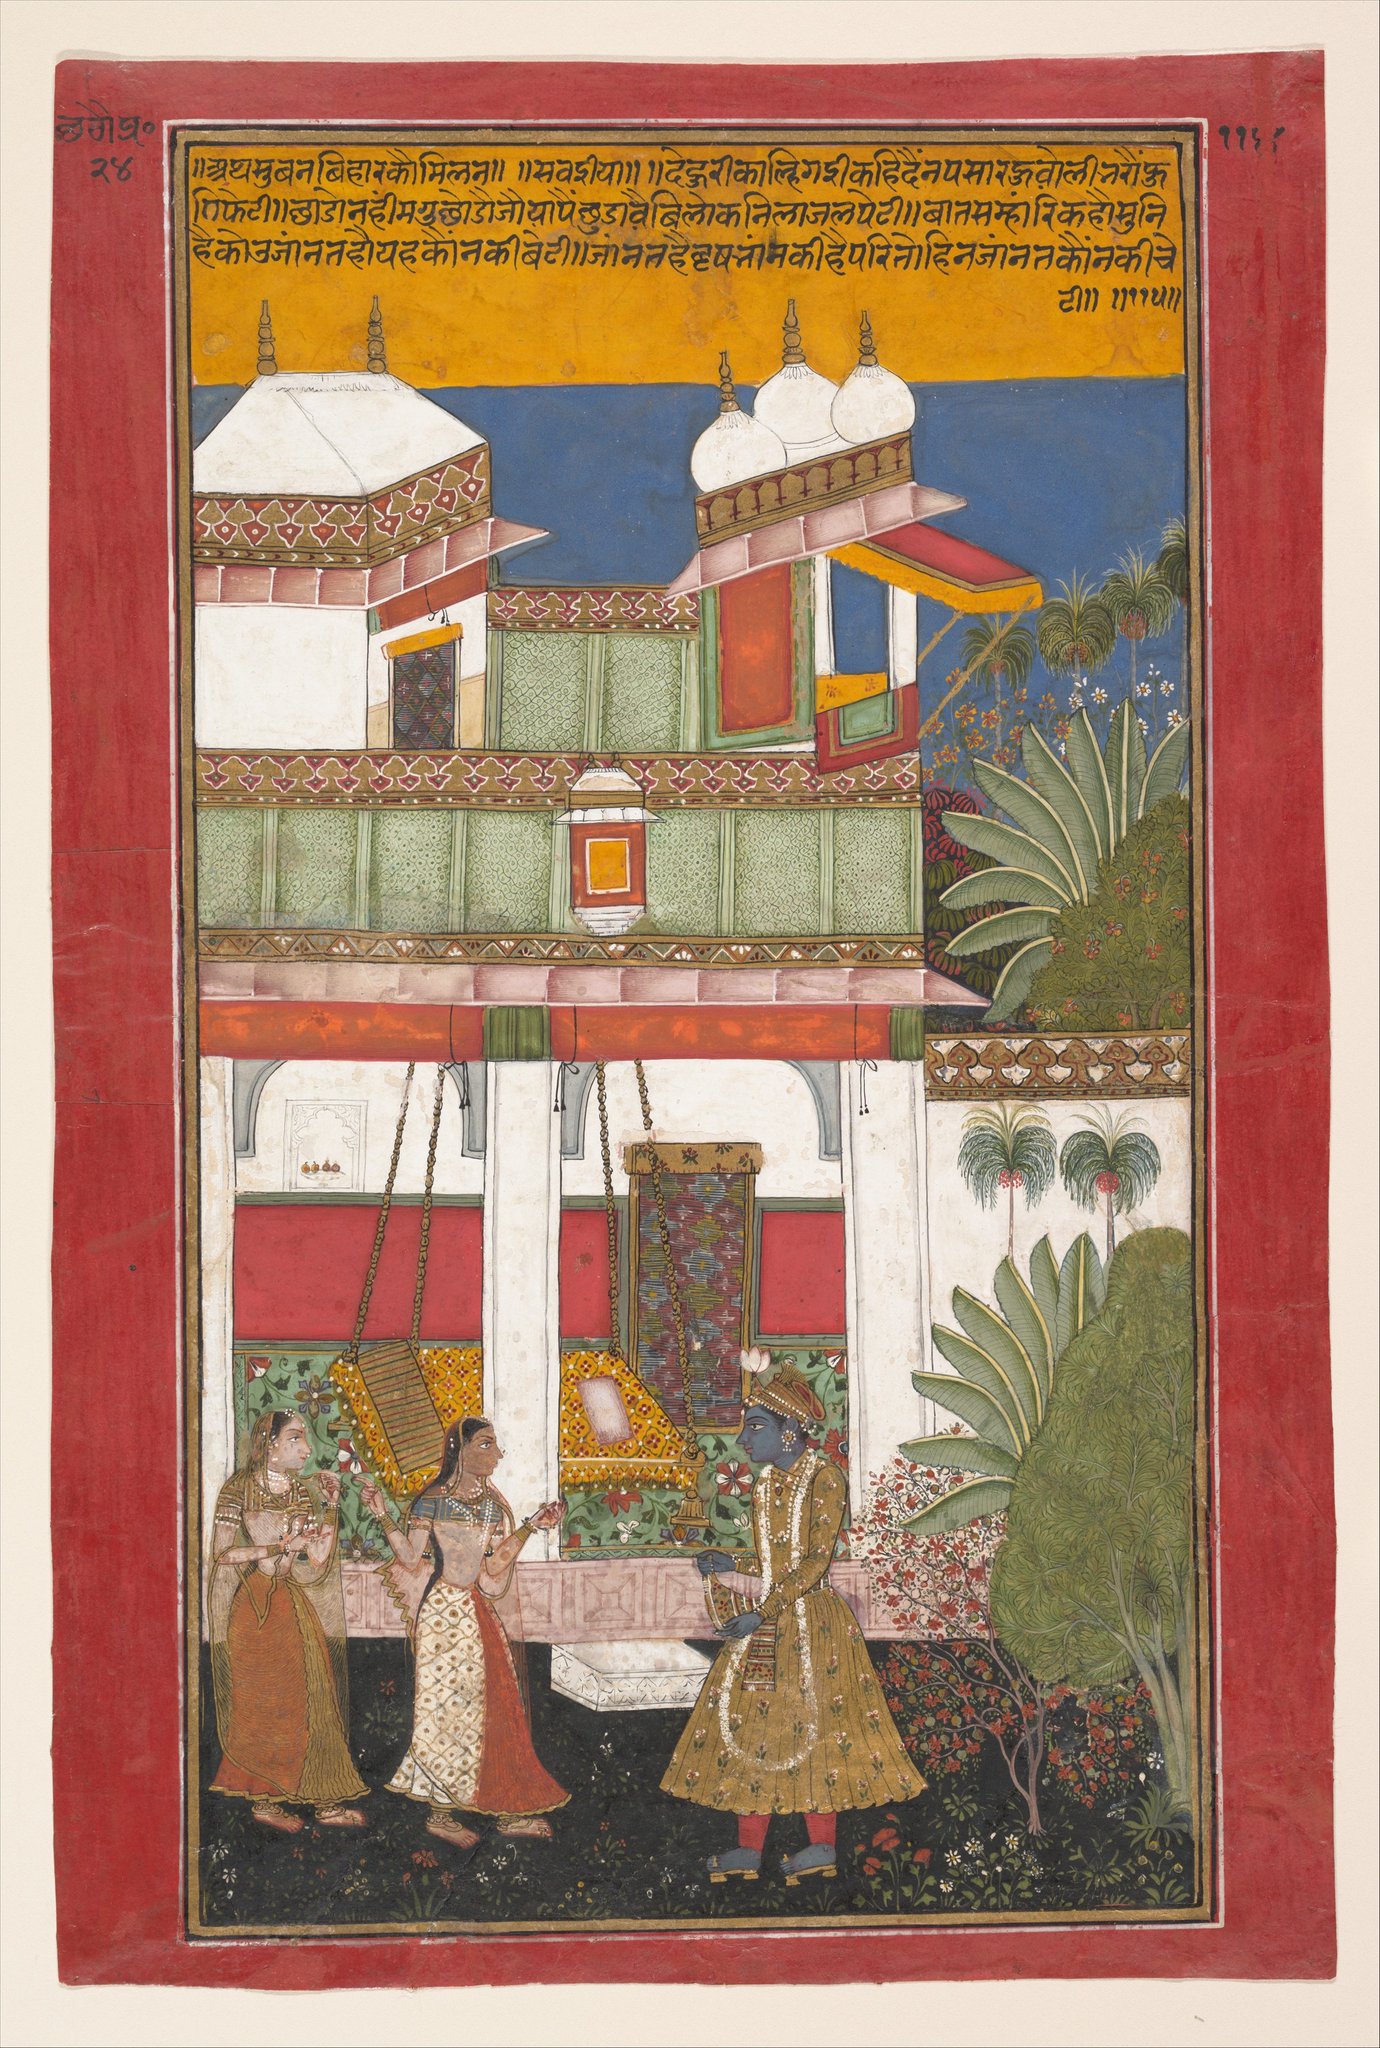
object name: page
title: Krishna and Radha, Page from a Dispersed Rasikapriya (Verses Celebrating Aspects of Love)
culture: indian or rajasthan or bundi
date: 1660-1670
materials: gold, ink, paper, watercolor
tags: krishna,radha,beds